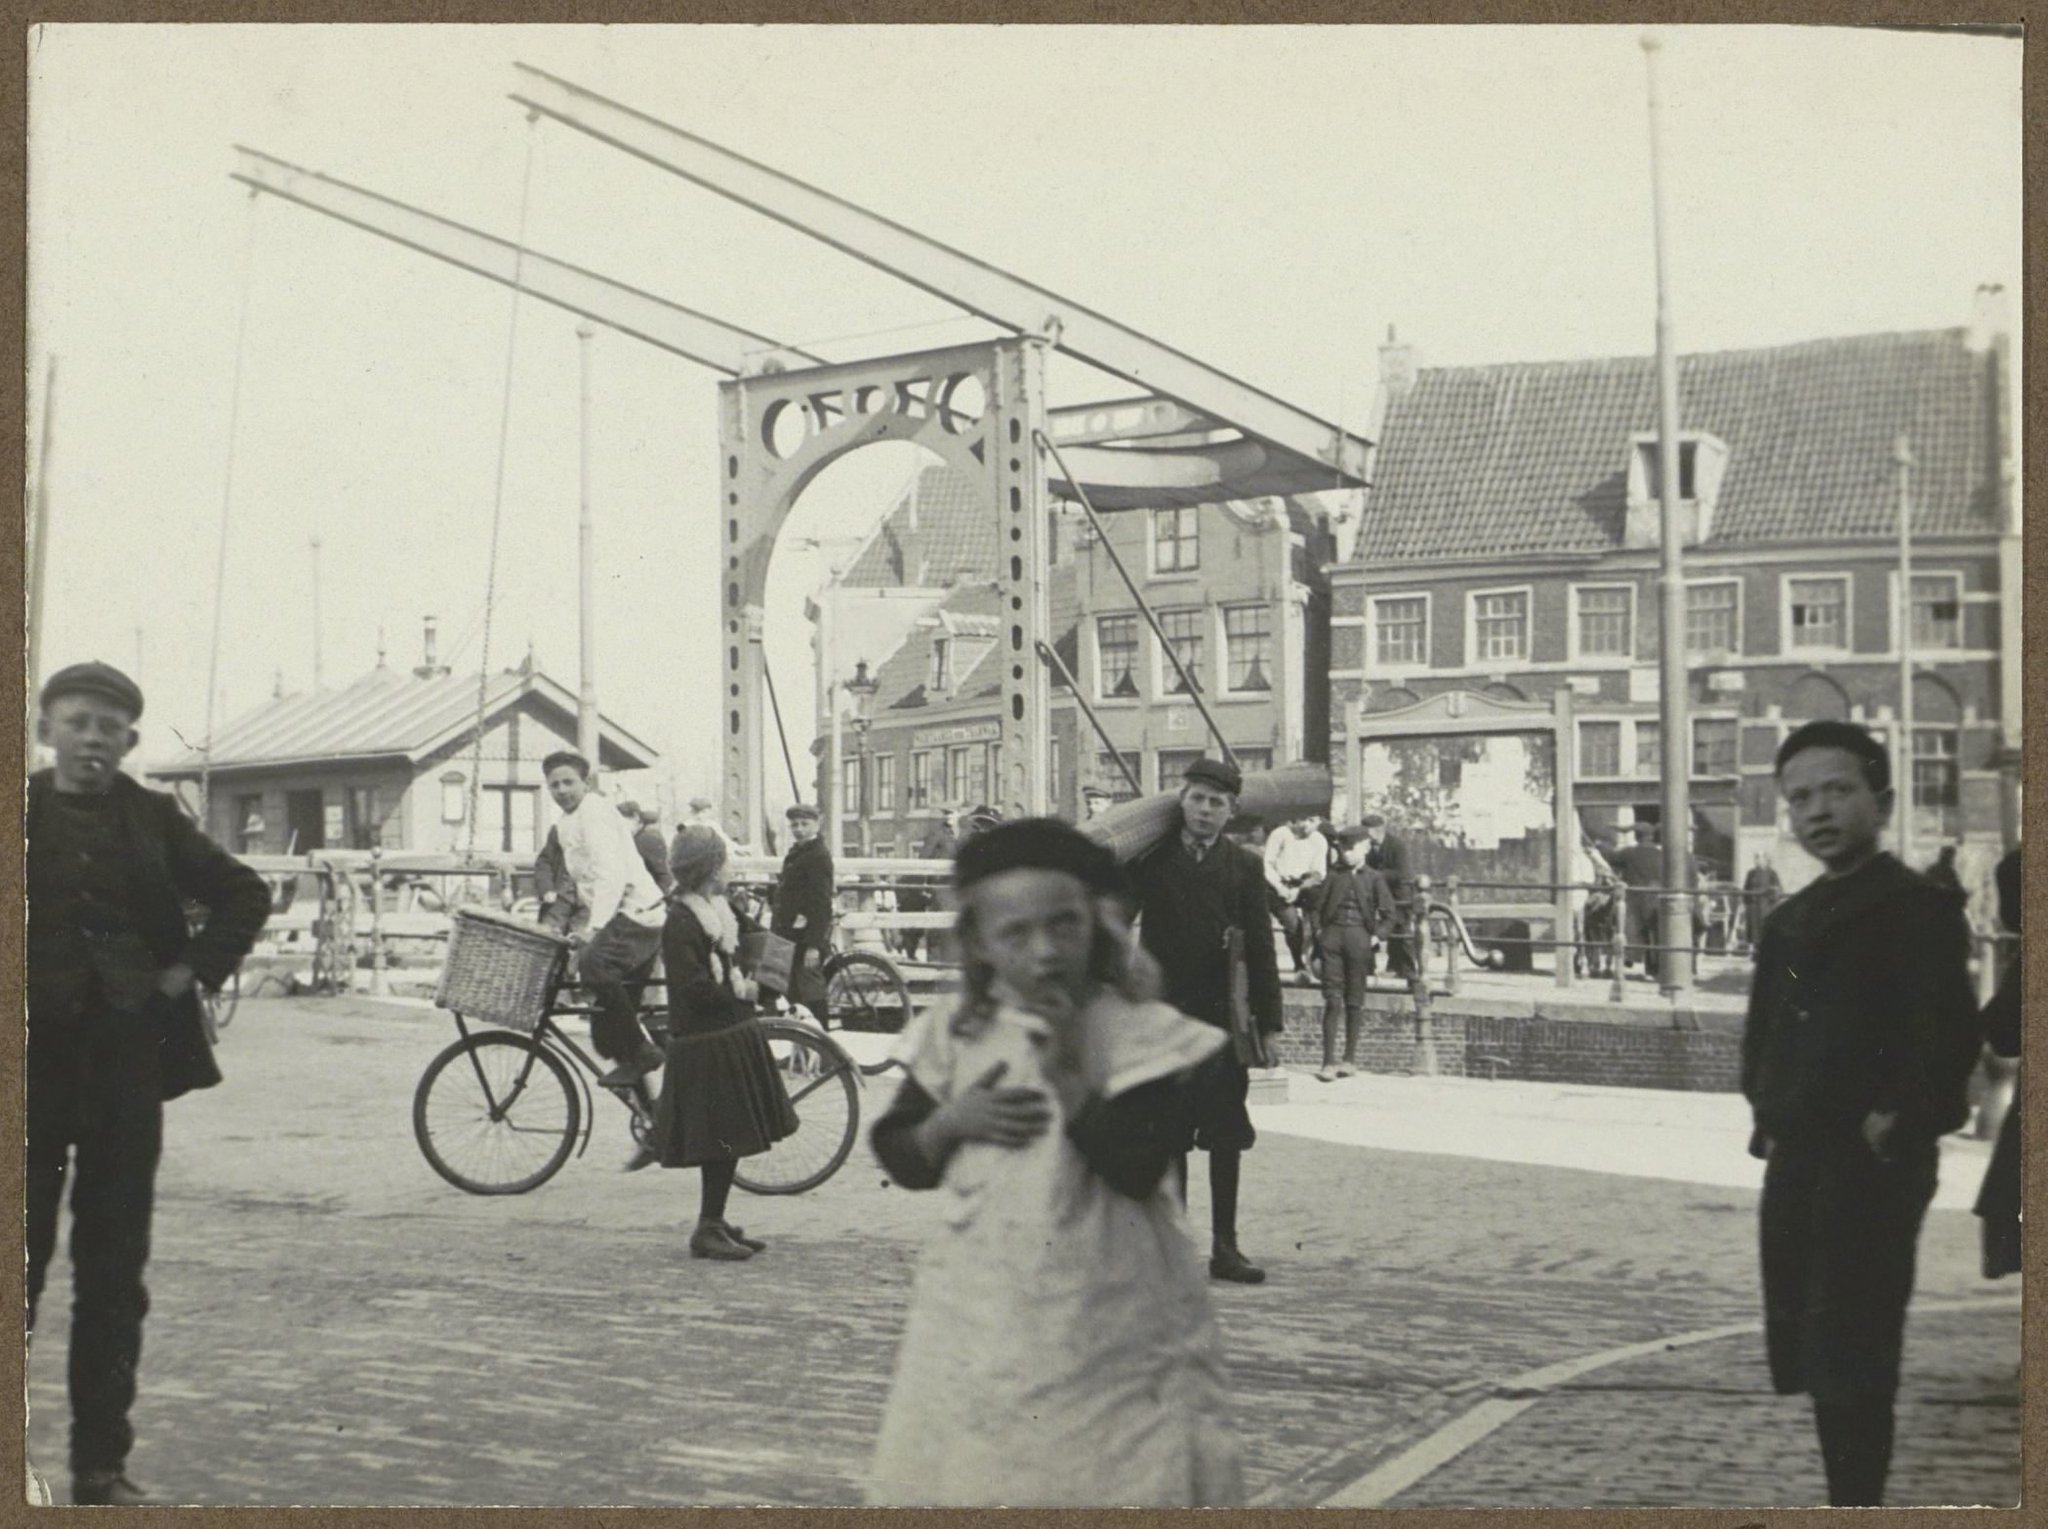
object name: photograph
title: Voorbijgangers en een bakkersknecht bij de brug over de Overtoomsesluis in Amsterdam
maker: Anonymous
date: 1910-1930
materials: paper, photographic support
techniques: gelatin silver print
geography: overtoom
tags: sluice, weir, bridge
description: Onderdeel van Album met foto's van Amsterdam en omgeving.